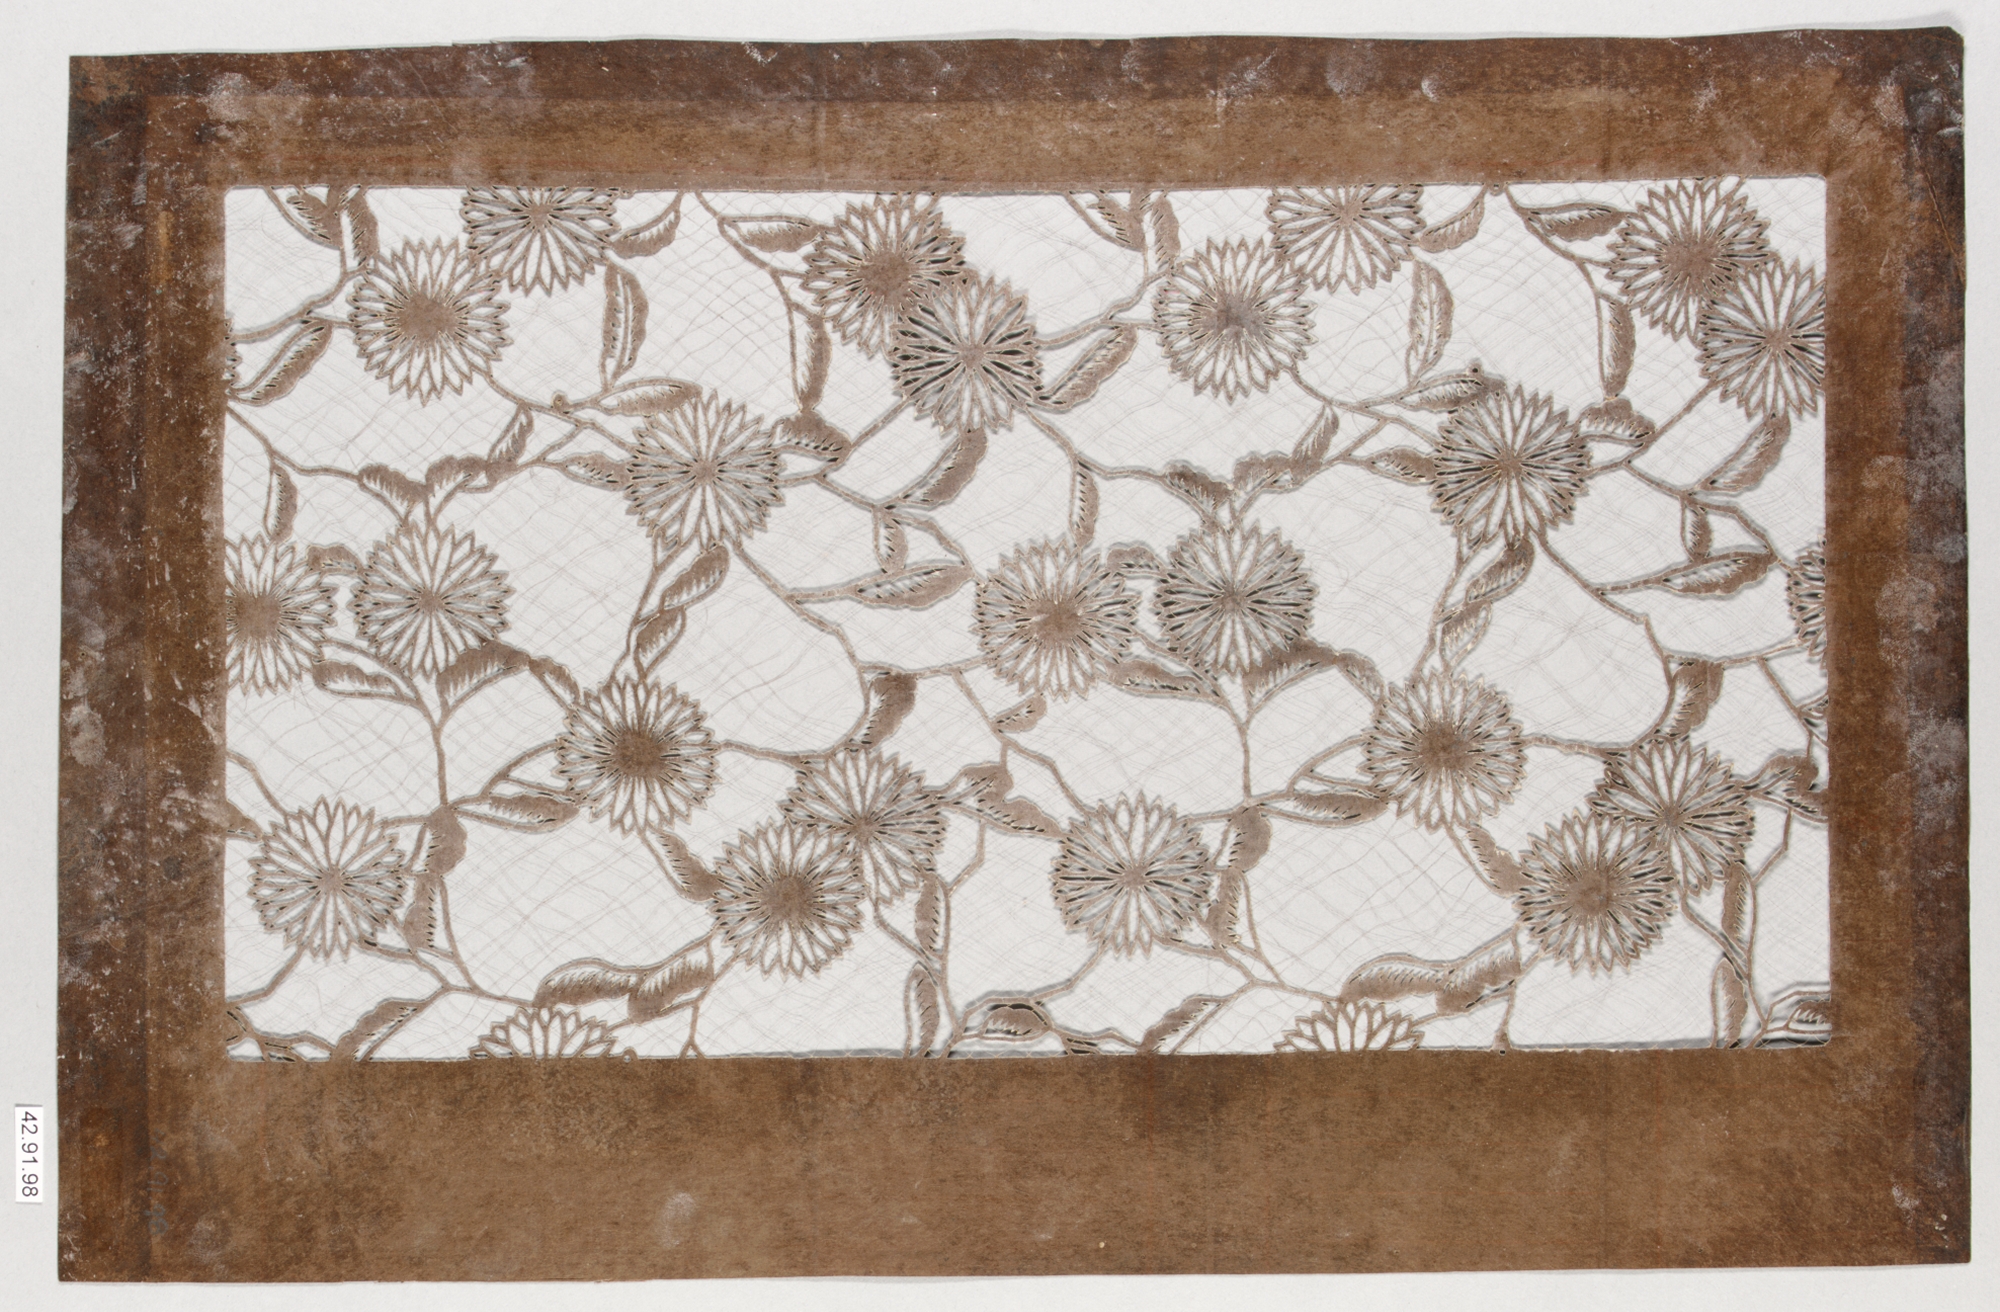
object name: stencil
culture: japanese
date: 1801-1900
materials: paper, silk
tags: flowers